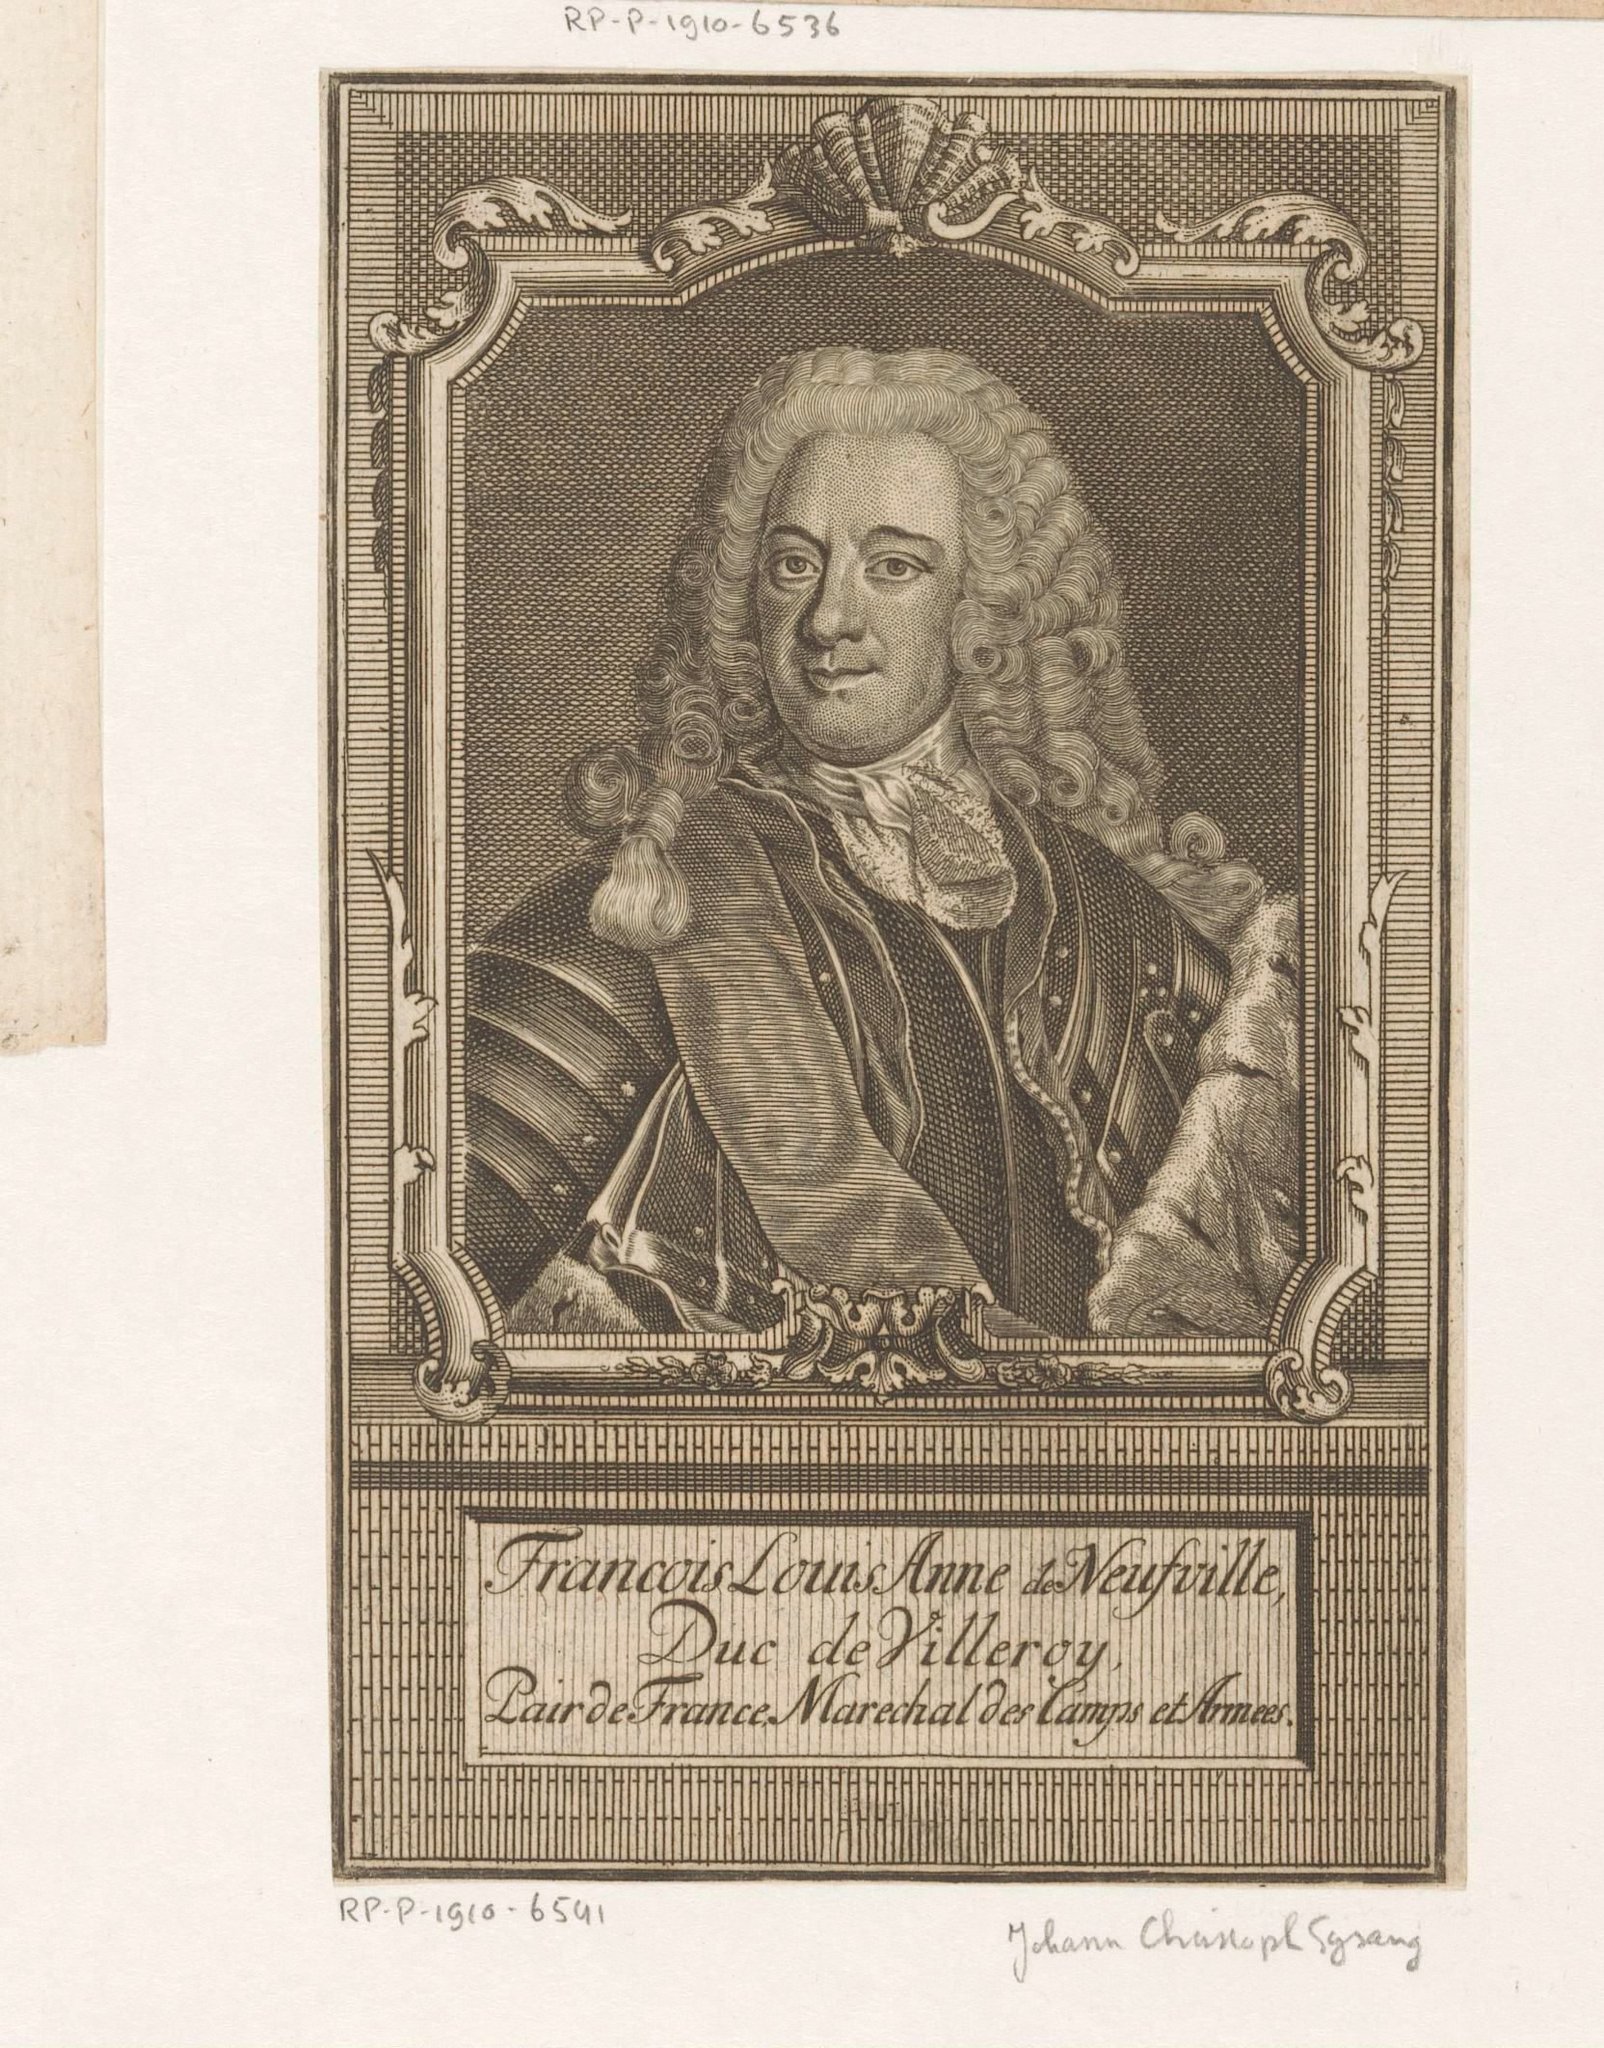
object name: print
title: Portret van Louis François Anne de Neufville, duc de Villeroy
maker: johann christoph sysang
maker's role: print maker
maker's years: 1703-1757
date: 1747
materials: paper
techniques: engraving, etching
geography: leipzig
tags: armour, historical persons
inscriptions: collector's mark: Lugt 2228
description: Prent ook gebruikt voor: Europäischer Staats-Secretarius (...) dl. 124, 1747.